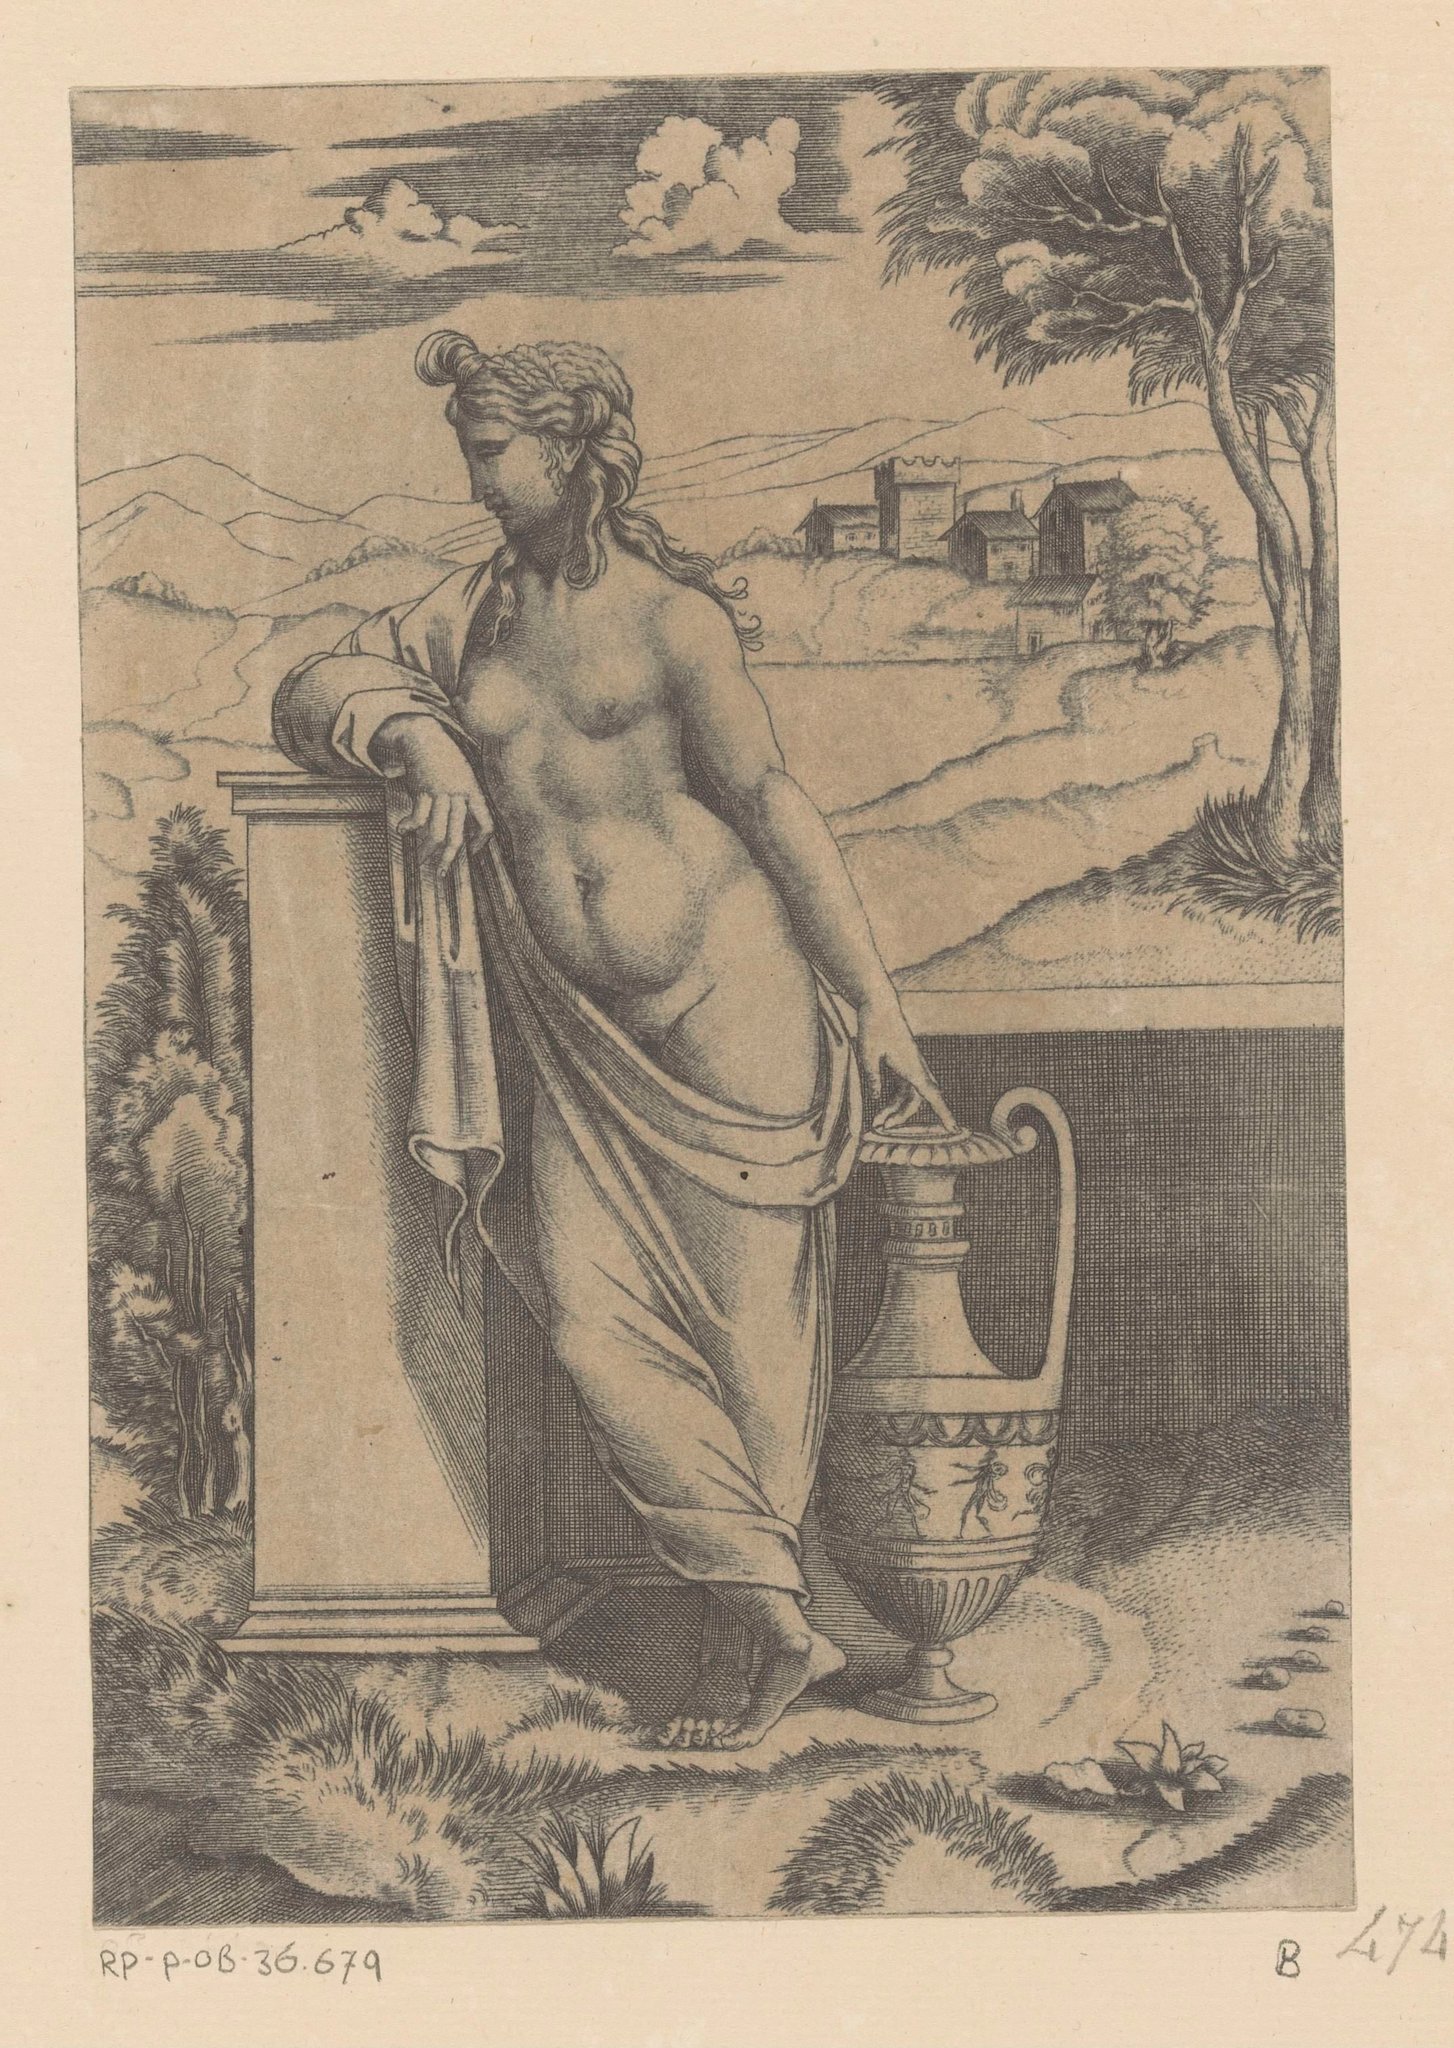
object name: print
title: Vrouw met amfoor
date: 1500-1536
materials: paper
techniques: engraving, etching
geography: italy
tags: city-view, and landscape with man-made constructions, the (nude) human figure; 'corpo humano' (ripa), container of stone: stone vase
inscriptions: collector's mark: Lugt 240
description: Een tekening met deze compositie in spiegelbeeld, gevat in een architectonische omlijsting, bevindt zich in het Musée du Louvre te Parijs (inv.nr. 3585).